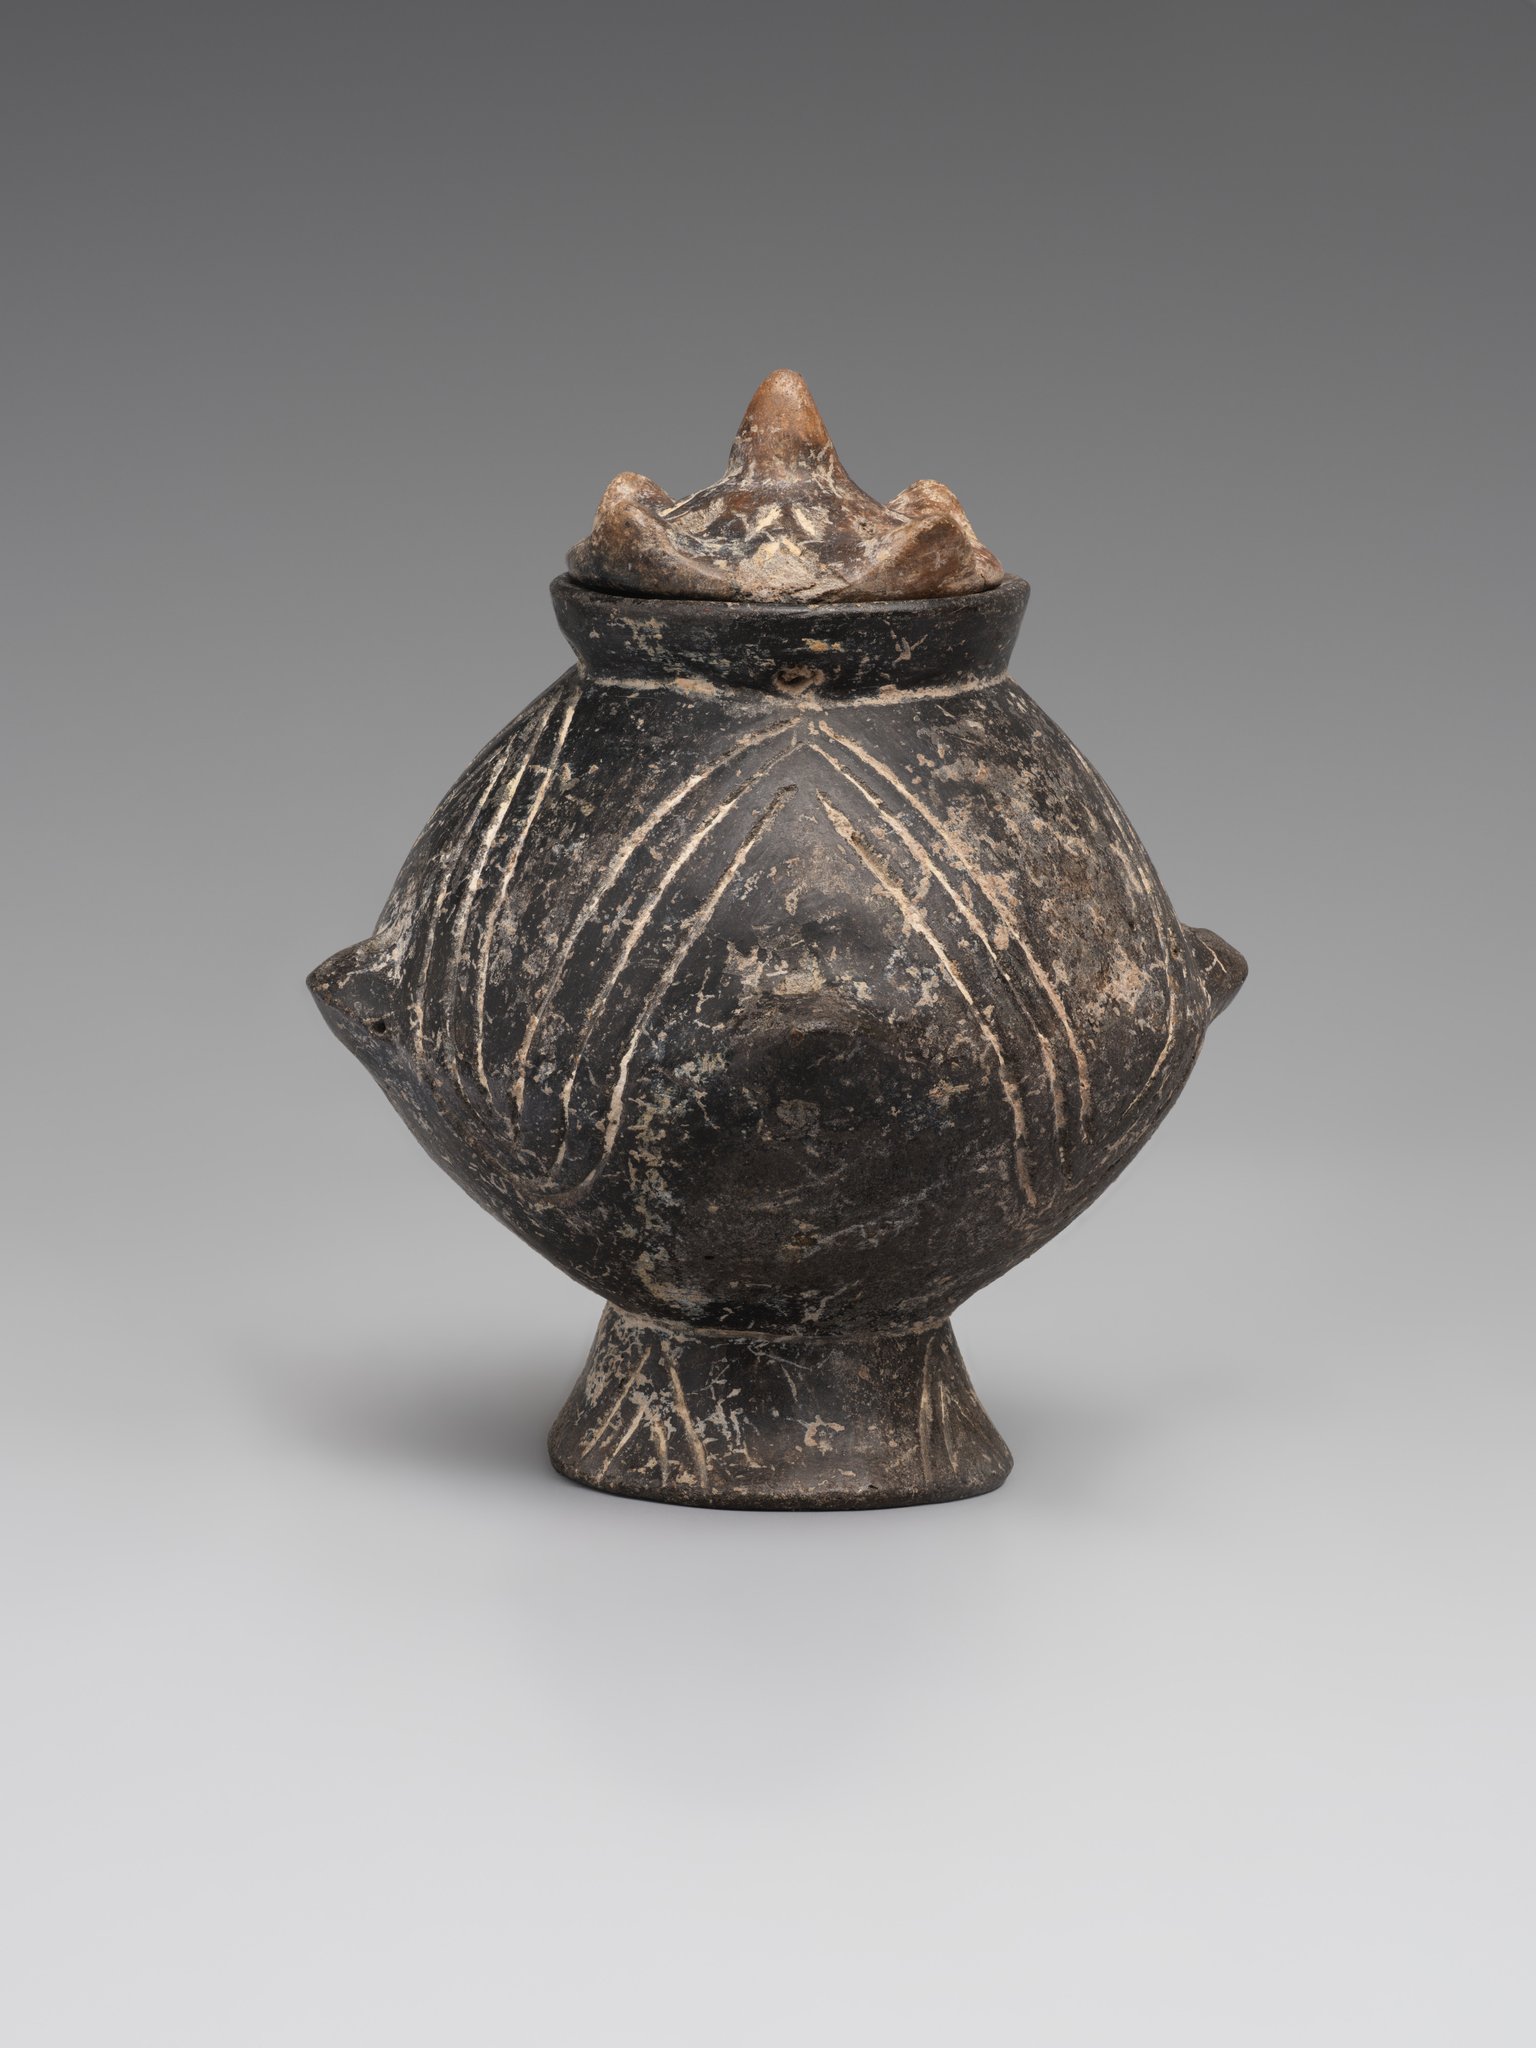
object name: vessel with lid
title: Vessel with a lid and incised decoration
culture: yortan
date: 2700-2400 BCE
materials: ceramic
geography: northwestern anatolia